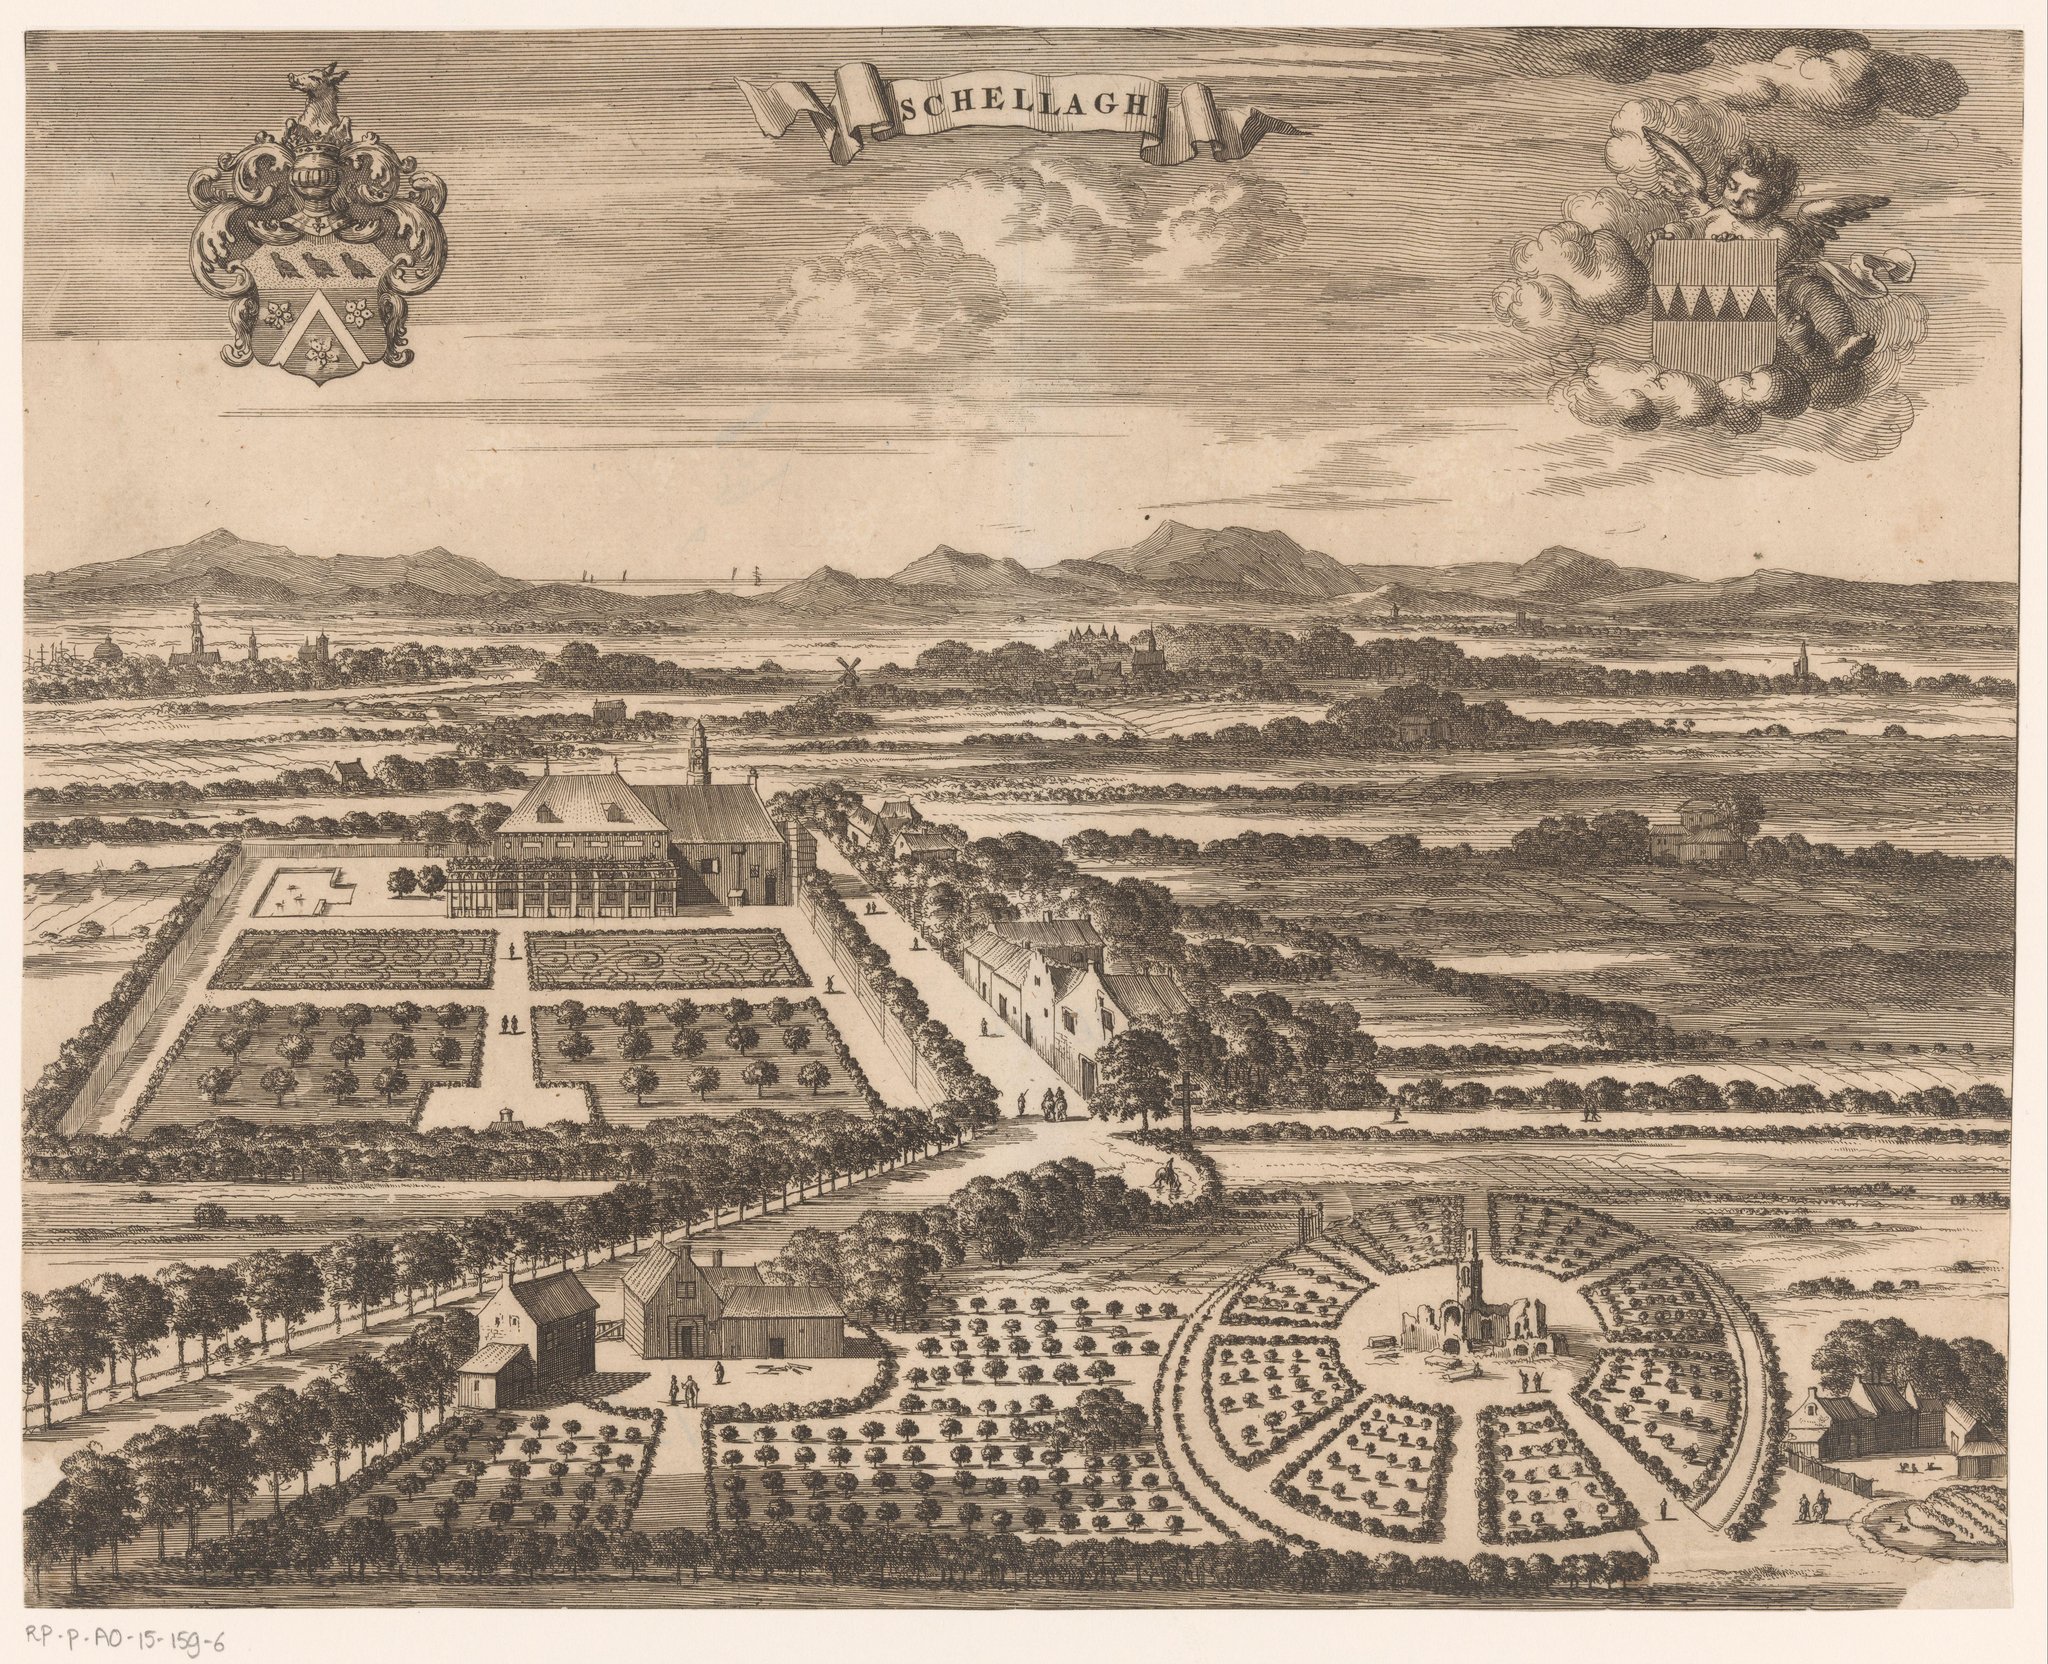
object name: book illustration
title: Gezicht op de heerlijkheid Schellach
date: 1696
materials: paper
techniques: engraving, etching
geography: amsterdam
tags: prospect of village, silhouette of village, coat of arms (as symbol of the state, etc.), ruins (garden ornaments), garden, french or architectonic garden; formal garden, armorial bearing, heraldry, country-house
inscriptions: collector's mark: Lugt 195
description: Gezicht op de heerlijkheid Schellach, gelegen tussen Middelburg en Veere, in vogelvluchtperspectief. Linksboven het wapen van de familie Boudaen Courten, die de heerlijkheid in haar bezit had sinds Hendrik Boudaen Courten het had gekocht. Boven in het midden een banderol met de titel. Rechtsboven een putto met het wapen van Brigdamme. Rechts op de voorgrond een ruïne als middelpunt van de aangelegen tuin van de hofstede.